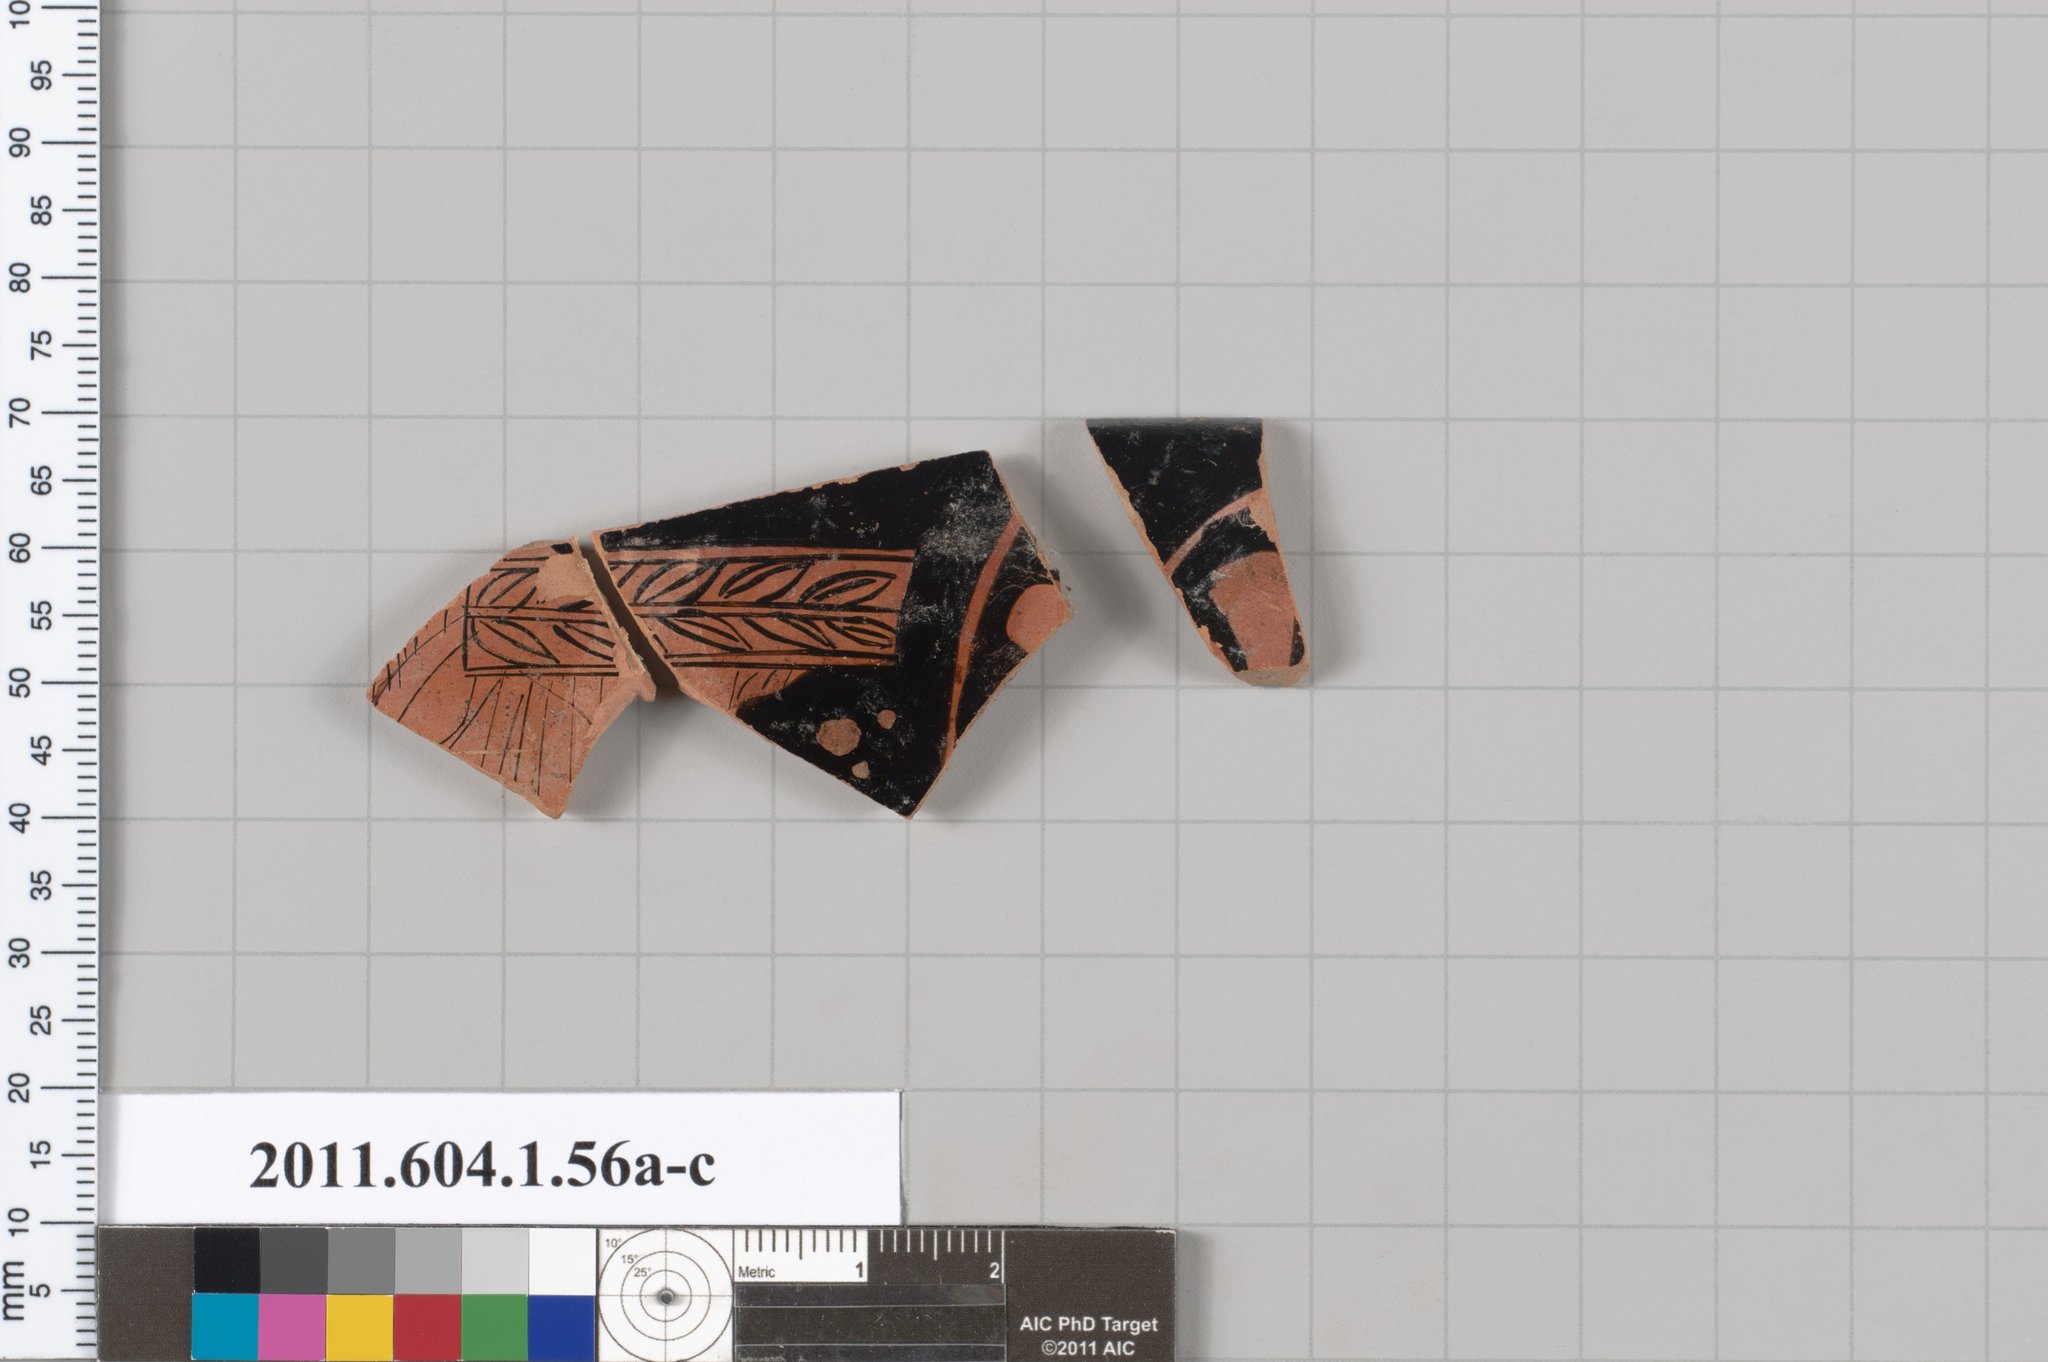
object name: kylix fragment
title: Terracotta fragments of a kylix (drinking cup)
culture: greek, attic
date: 467-435 BCE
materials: terracotta